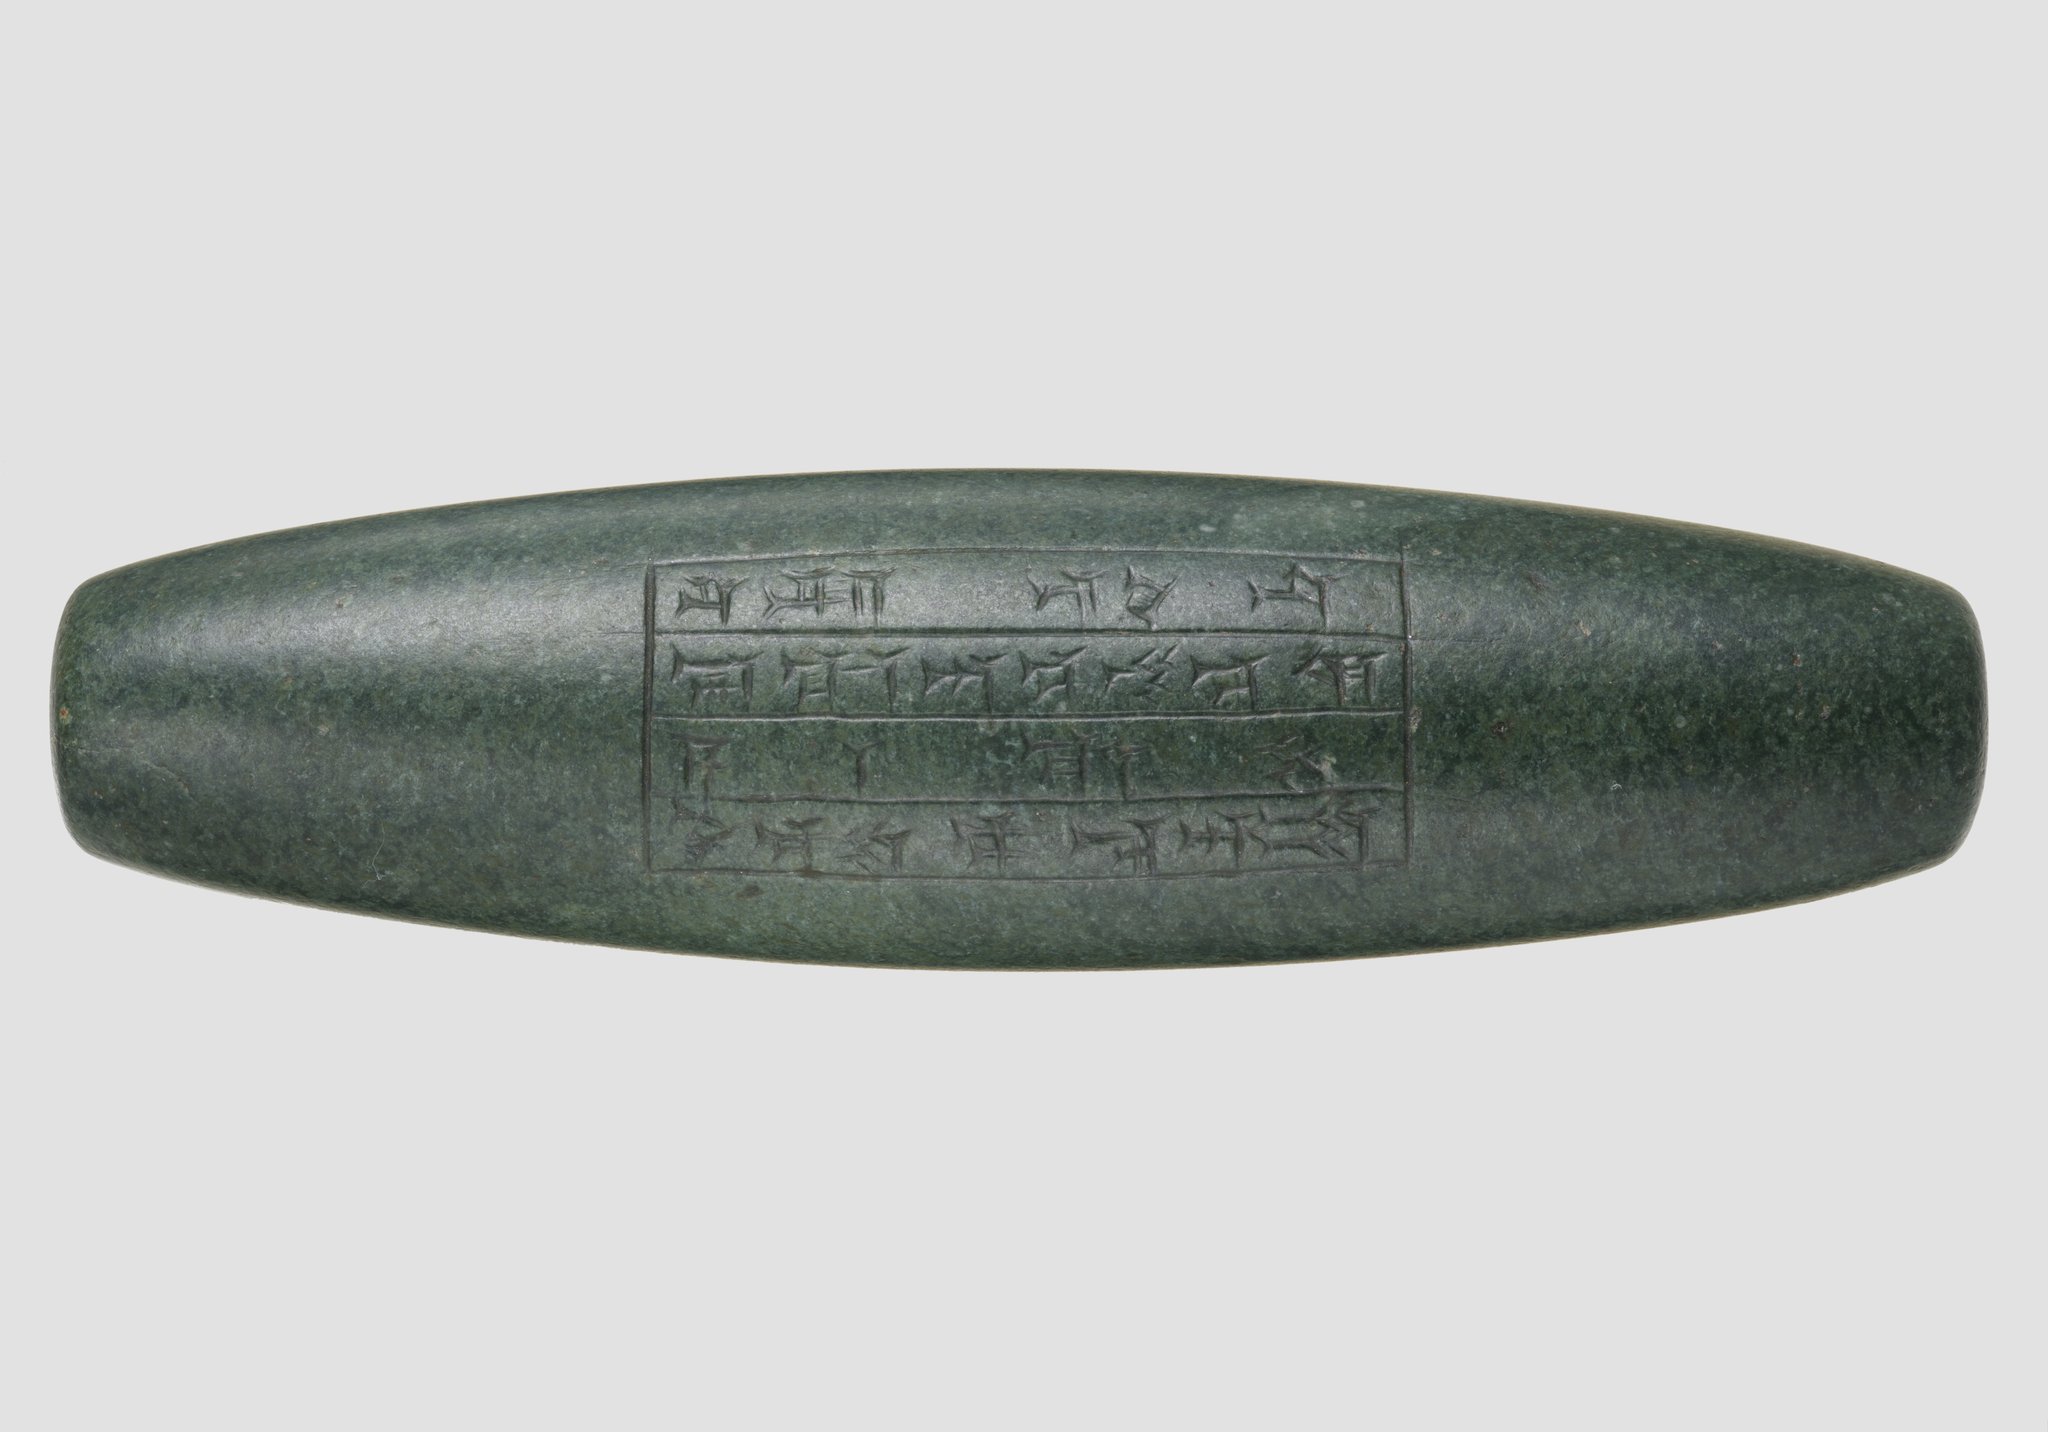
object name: weight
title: Inscribed weight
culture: babylonian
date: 900-701 BCE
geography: cyprus or mesopotamia